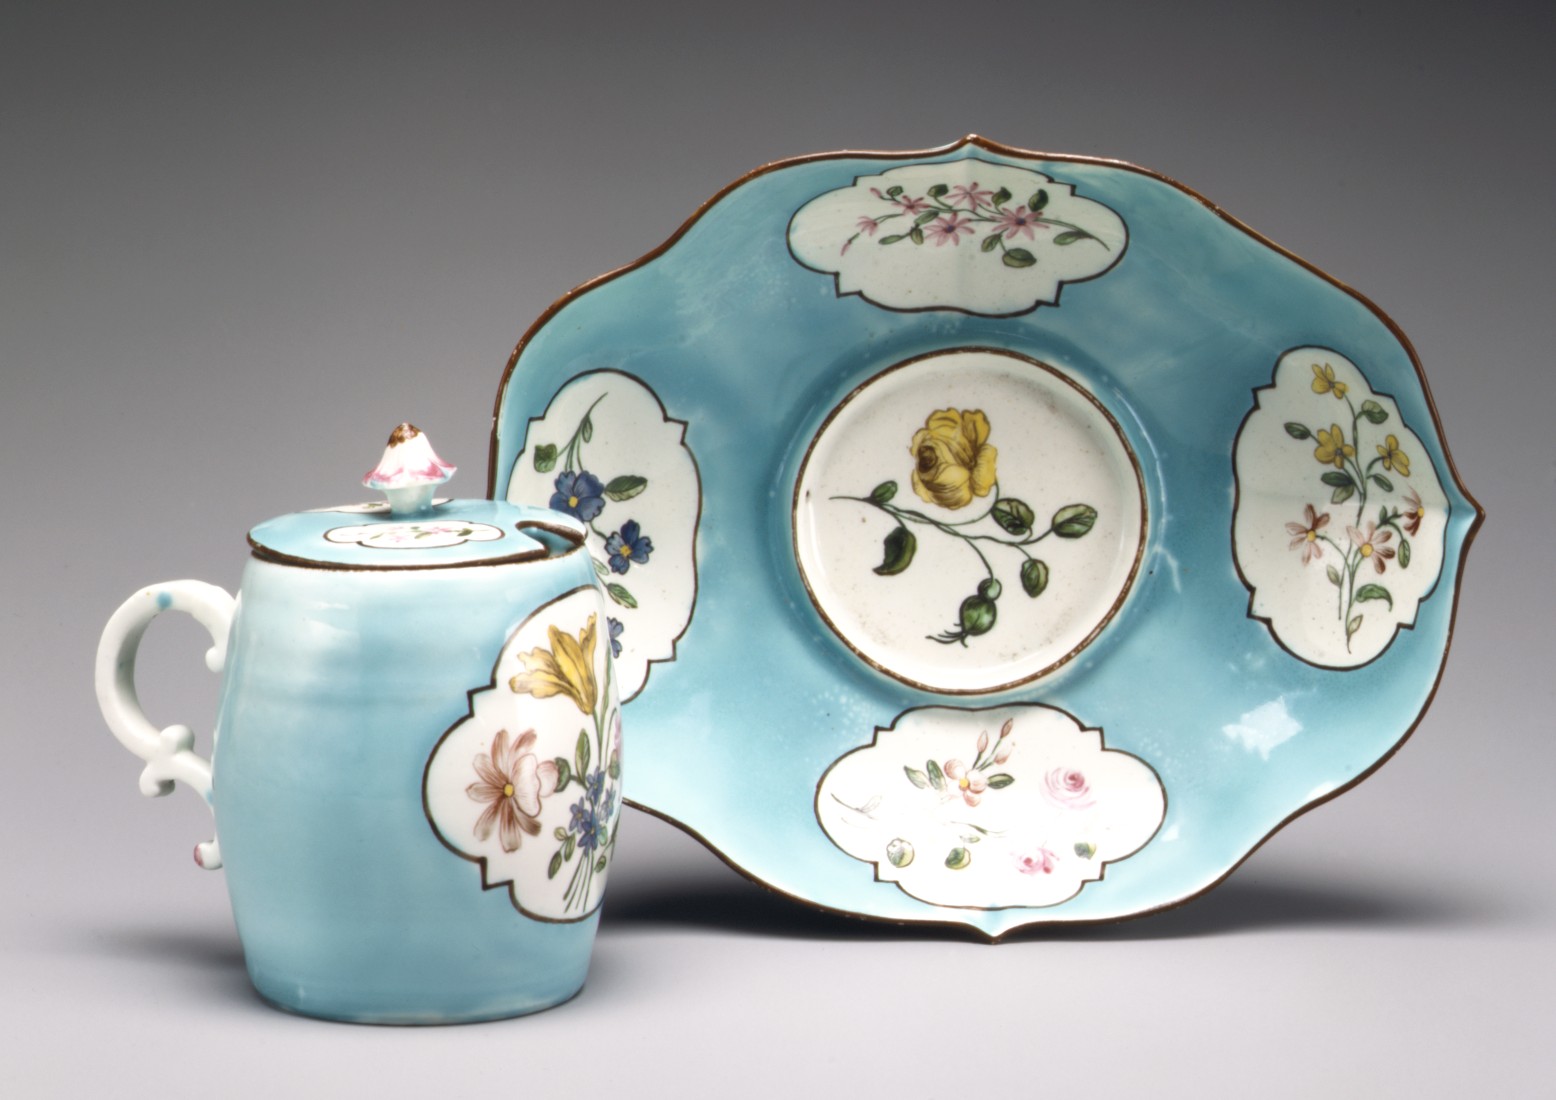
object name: mustard pot with cover and stand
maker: chantilly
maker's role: factory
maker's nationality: french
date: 1745-1755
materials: soft paste porcelain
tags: flowers